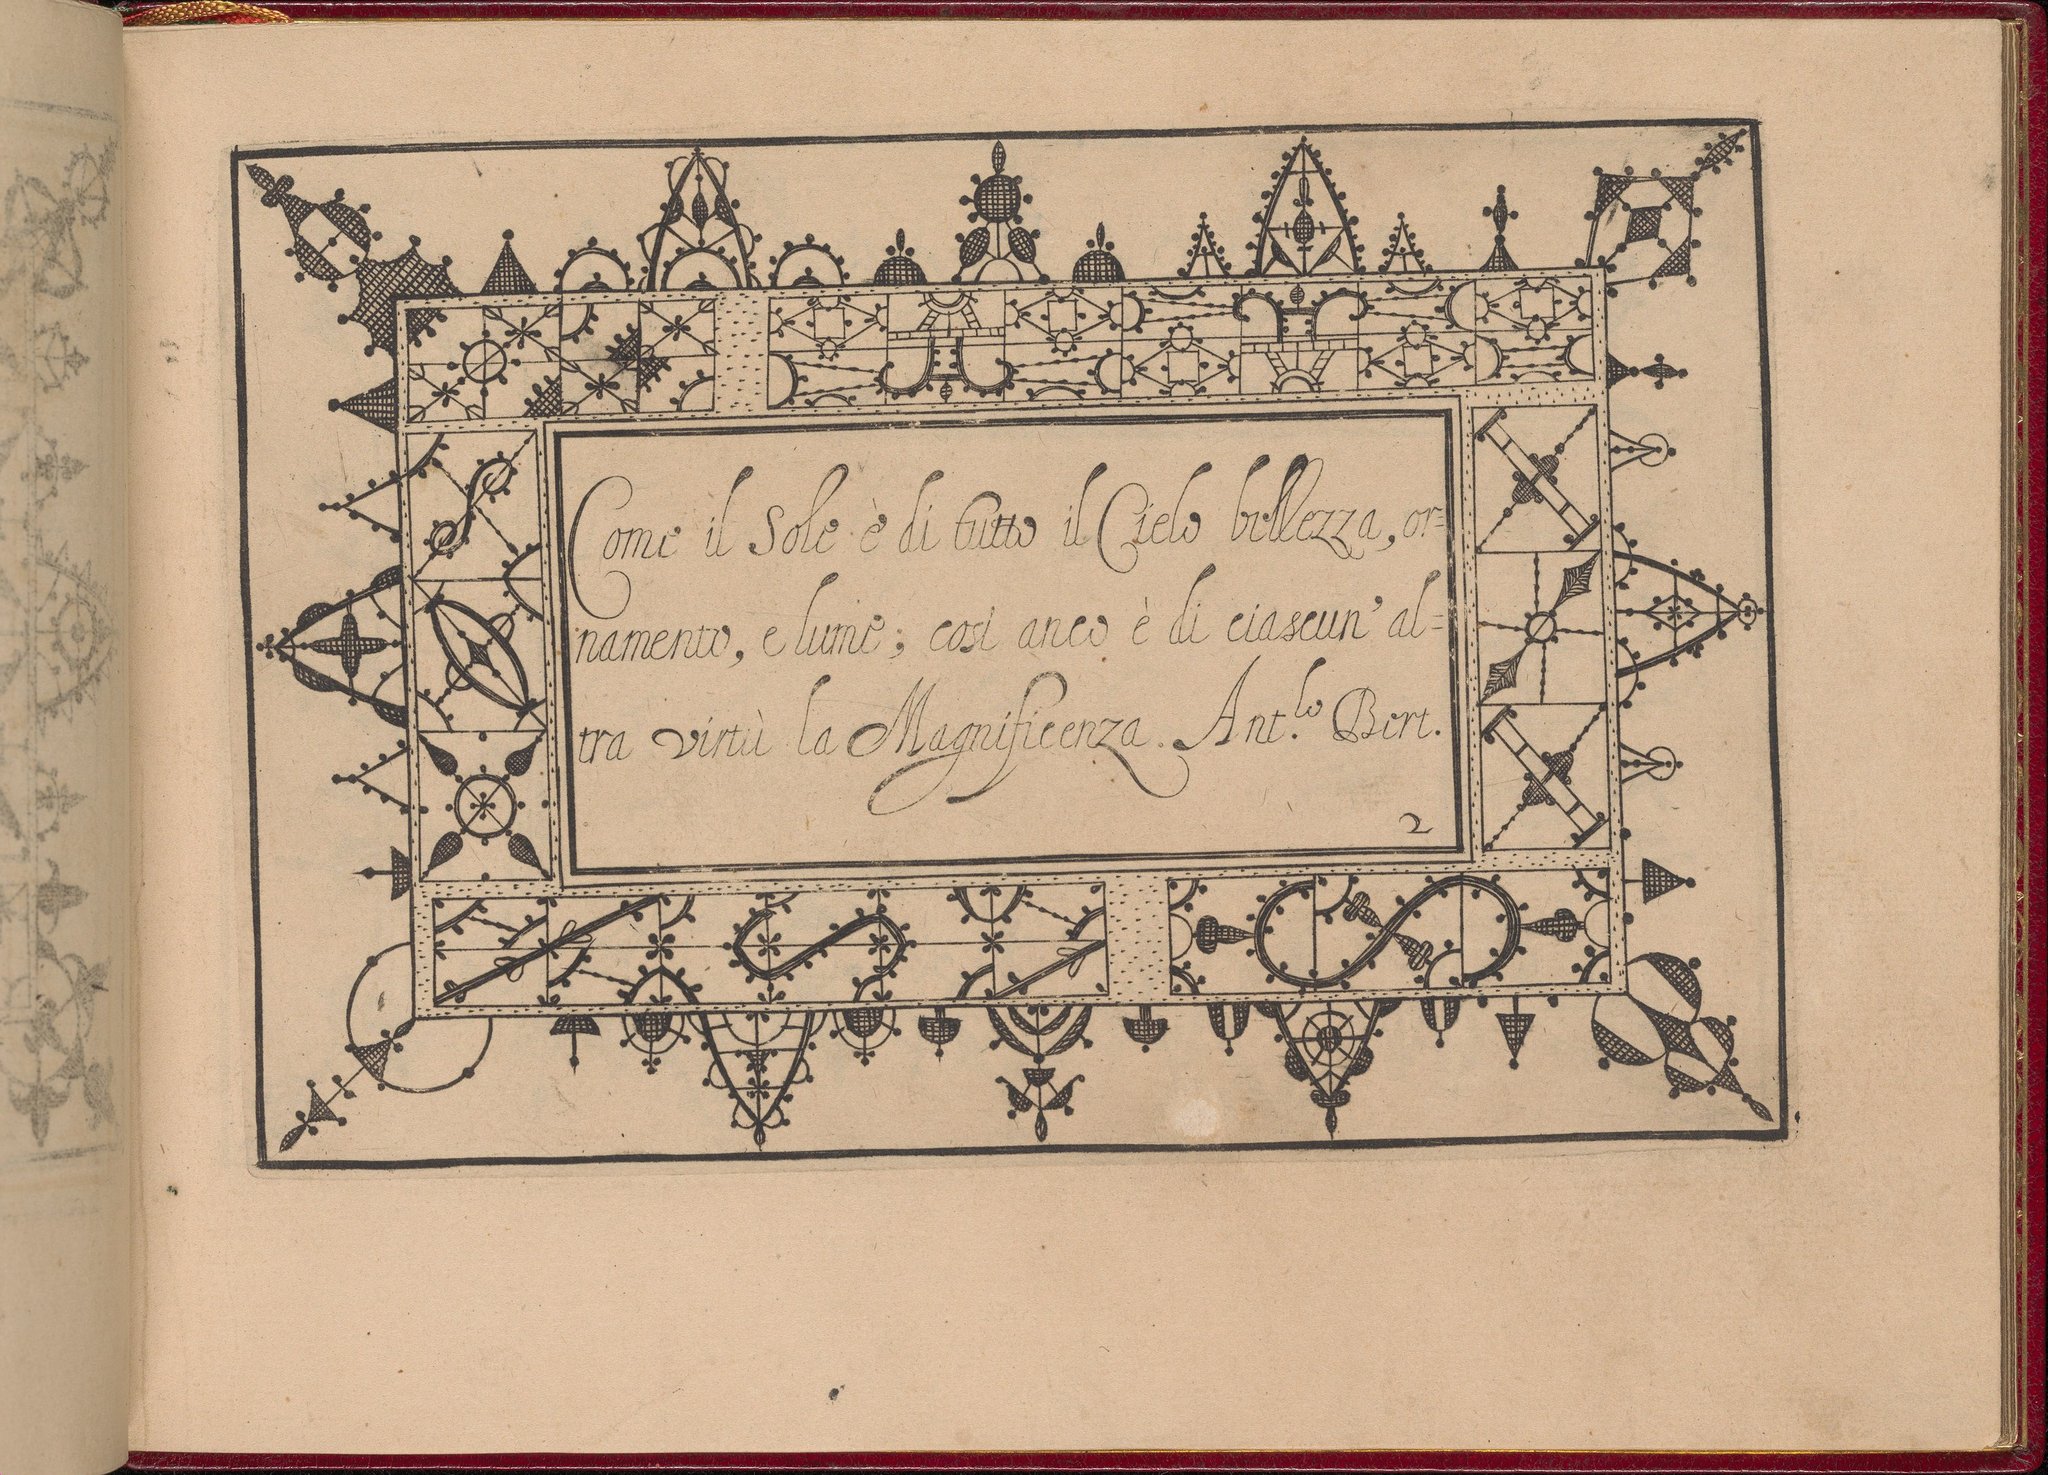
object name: book print ornament architecture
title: Ghirlanda: Di sei vaghi fiori scielti da piu famosi Giardini d'Italia, page 10 (recto)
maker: pietro paulo tozzi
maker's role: designer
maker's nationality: italian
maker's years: 1593-1628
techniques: drawing, etching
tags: ornament